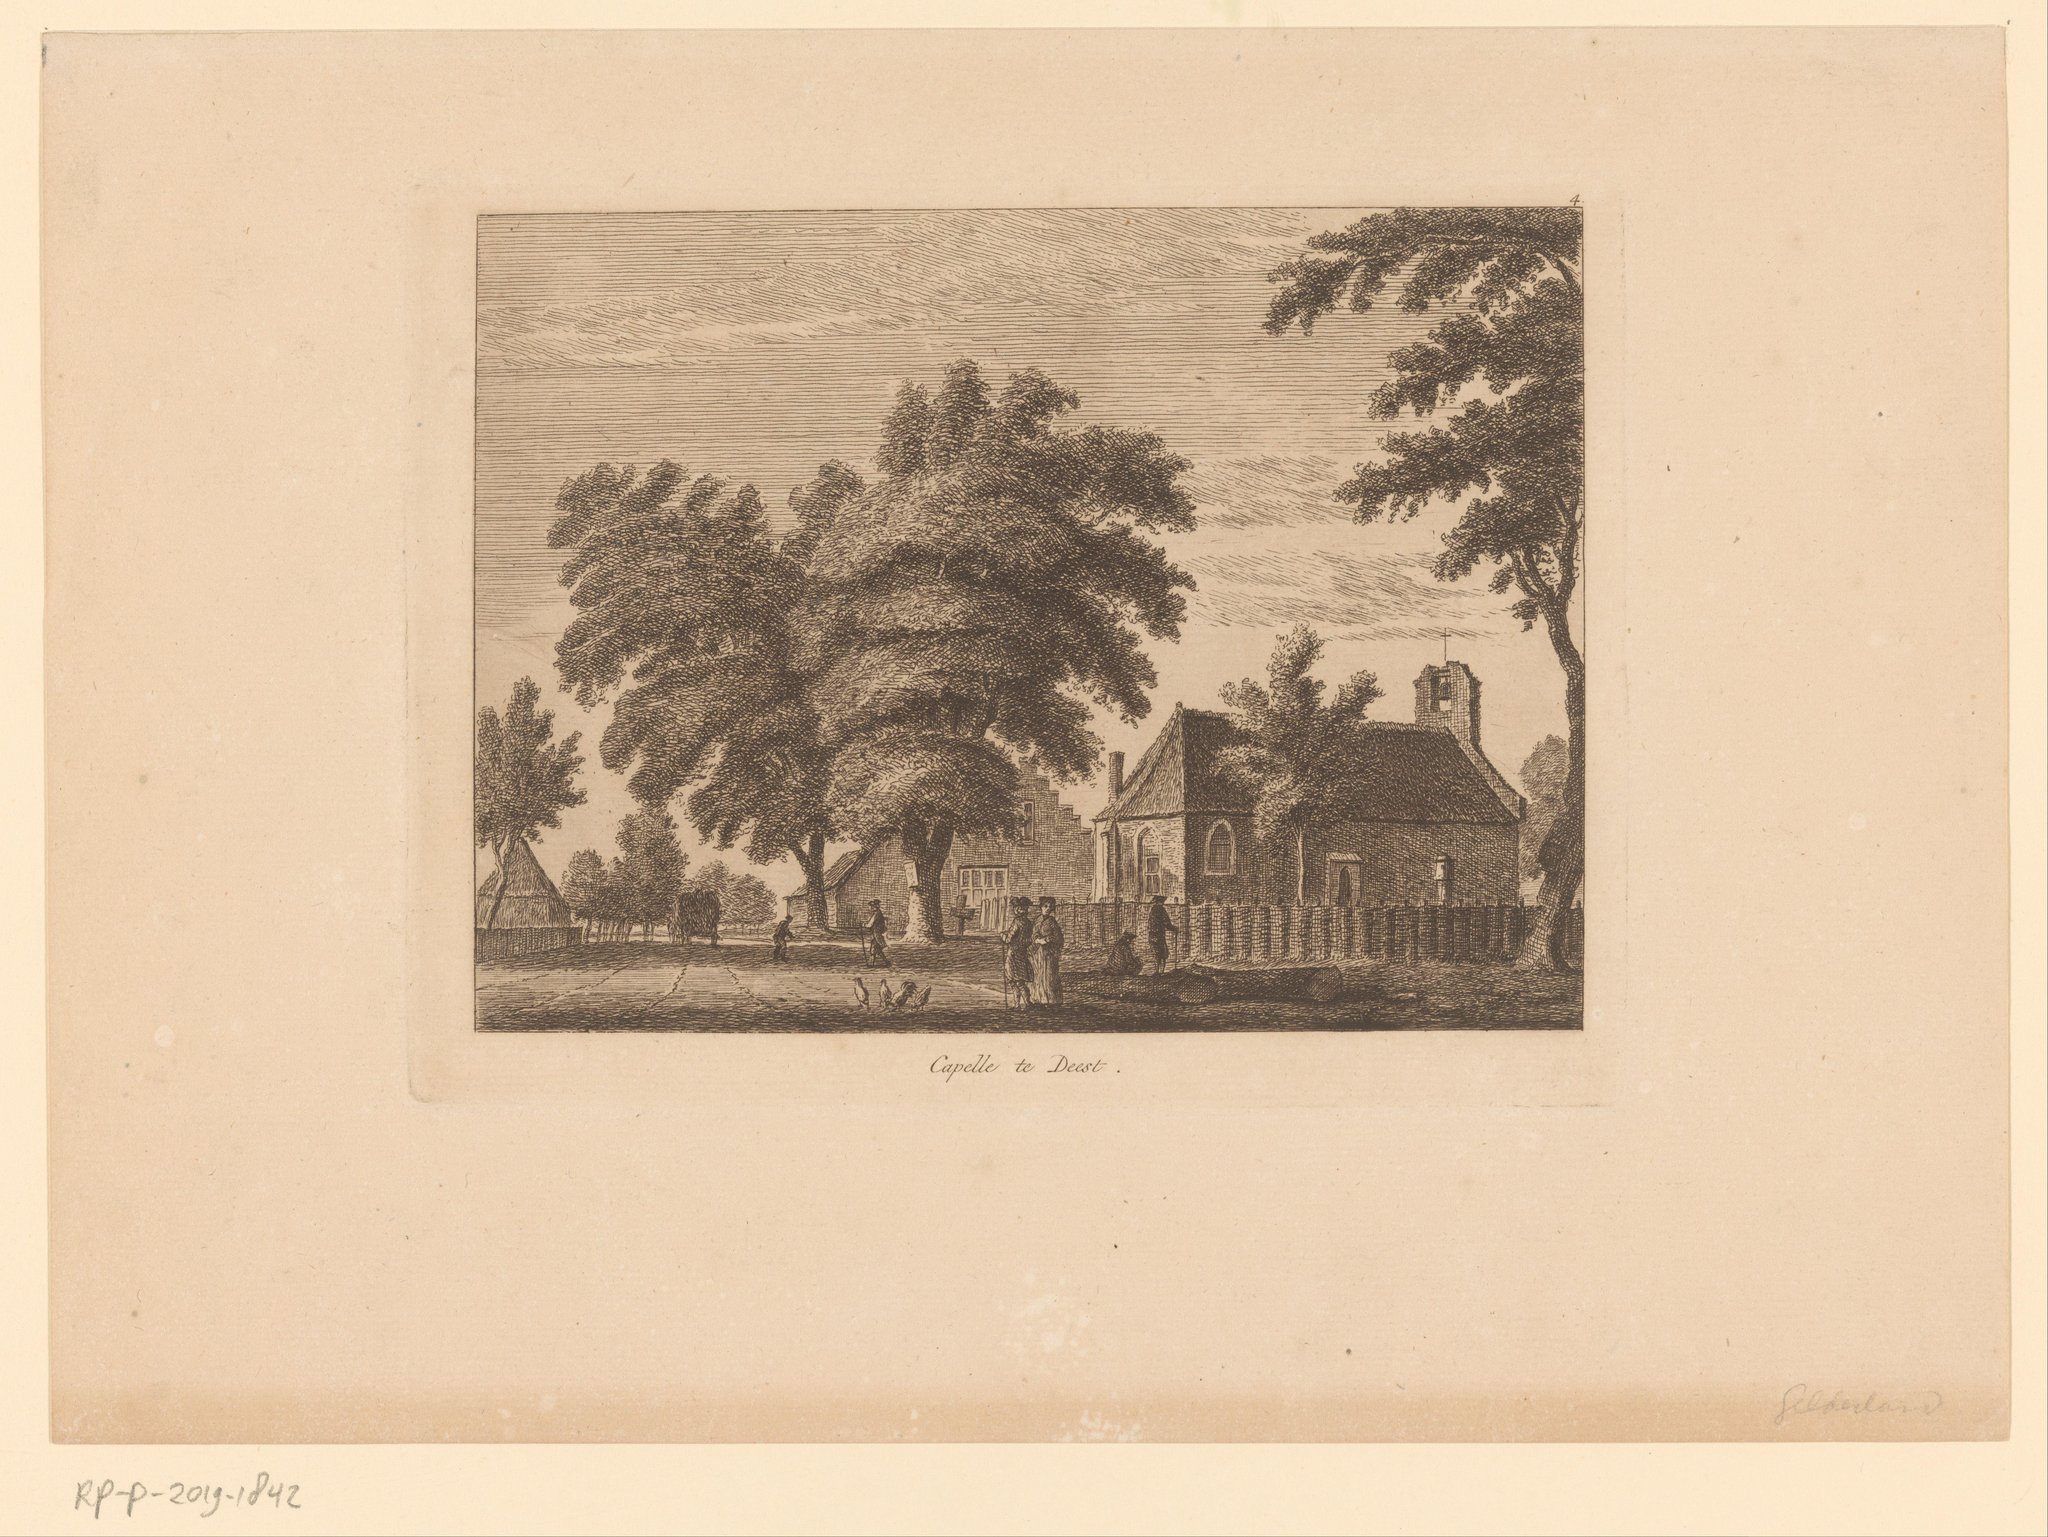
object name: print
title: Nederlandse dorpsgezichten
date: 1770-1800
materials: paper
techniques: etching, intaglio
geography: amsterdam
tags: church (exterior), village (+ city(-scape) with figures, staffage)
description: Prent mogelijk uit: Gezichten voorname Hollandse dorpen. Amsterdam: Pierre Fouquet, s.a.